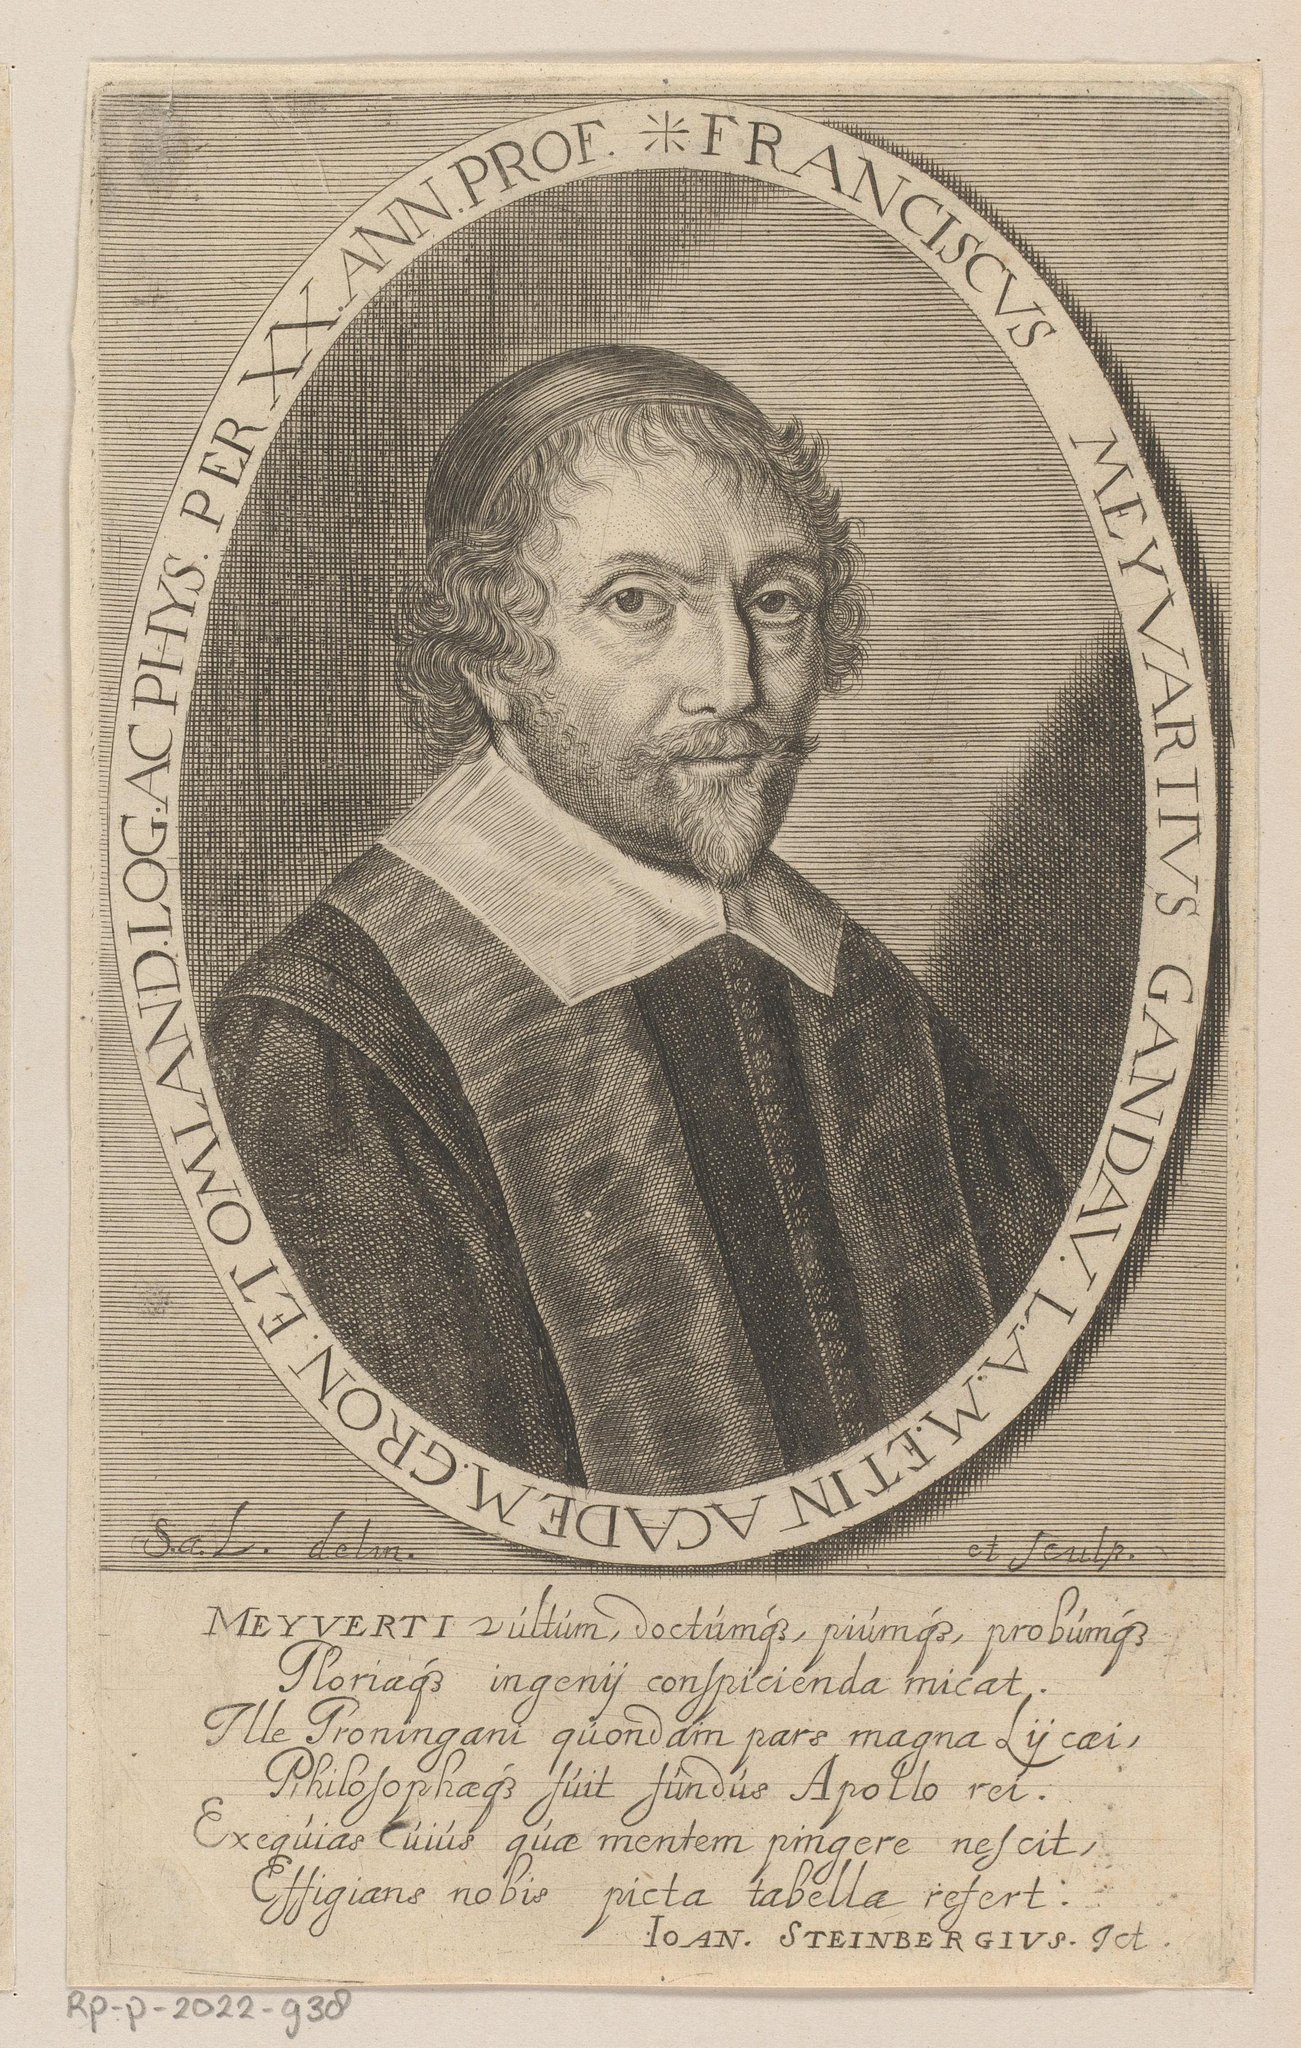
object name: book illustration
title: Portret van Franciscus Meyvartius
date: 1654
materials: paper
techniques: engraving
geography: utrecht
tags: historical persons, professor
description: Portret waarschijnlijk uit: Effigies & vitae Professorvm Academiae Groningae & Omlandiae. Groningen: Hindrick Lussinck en Jan Claessen, 1654.